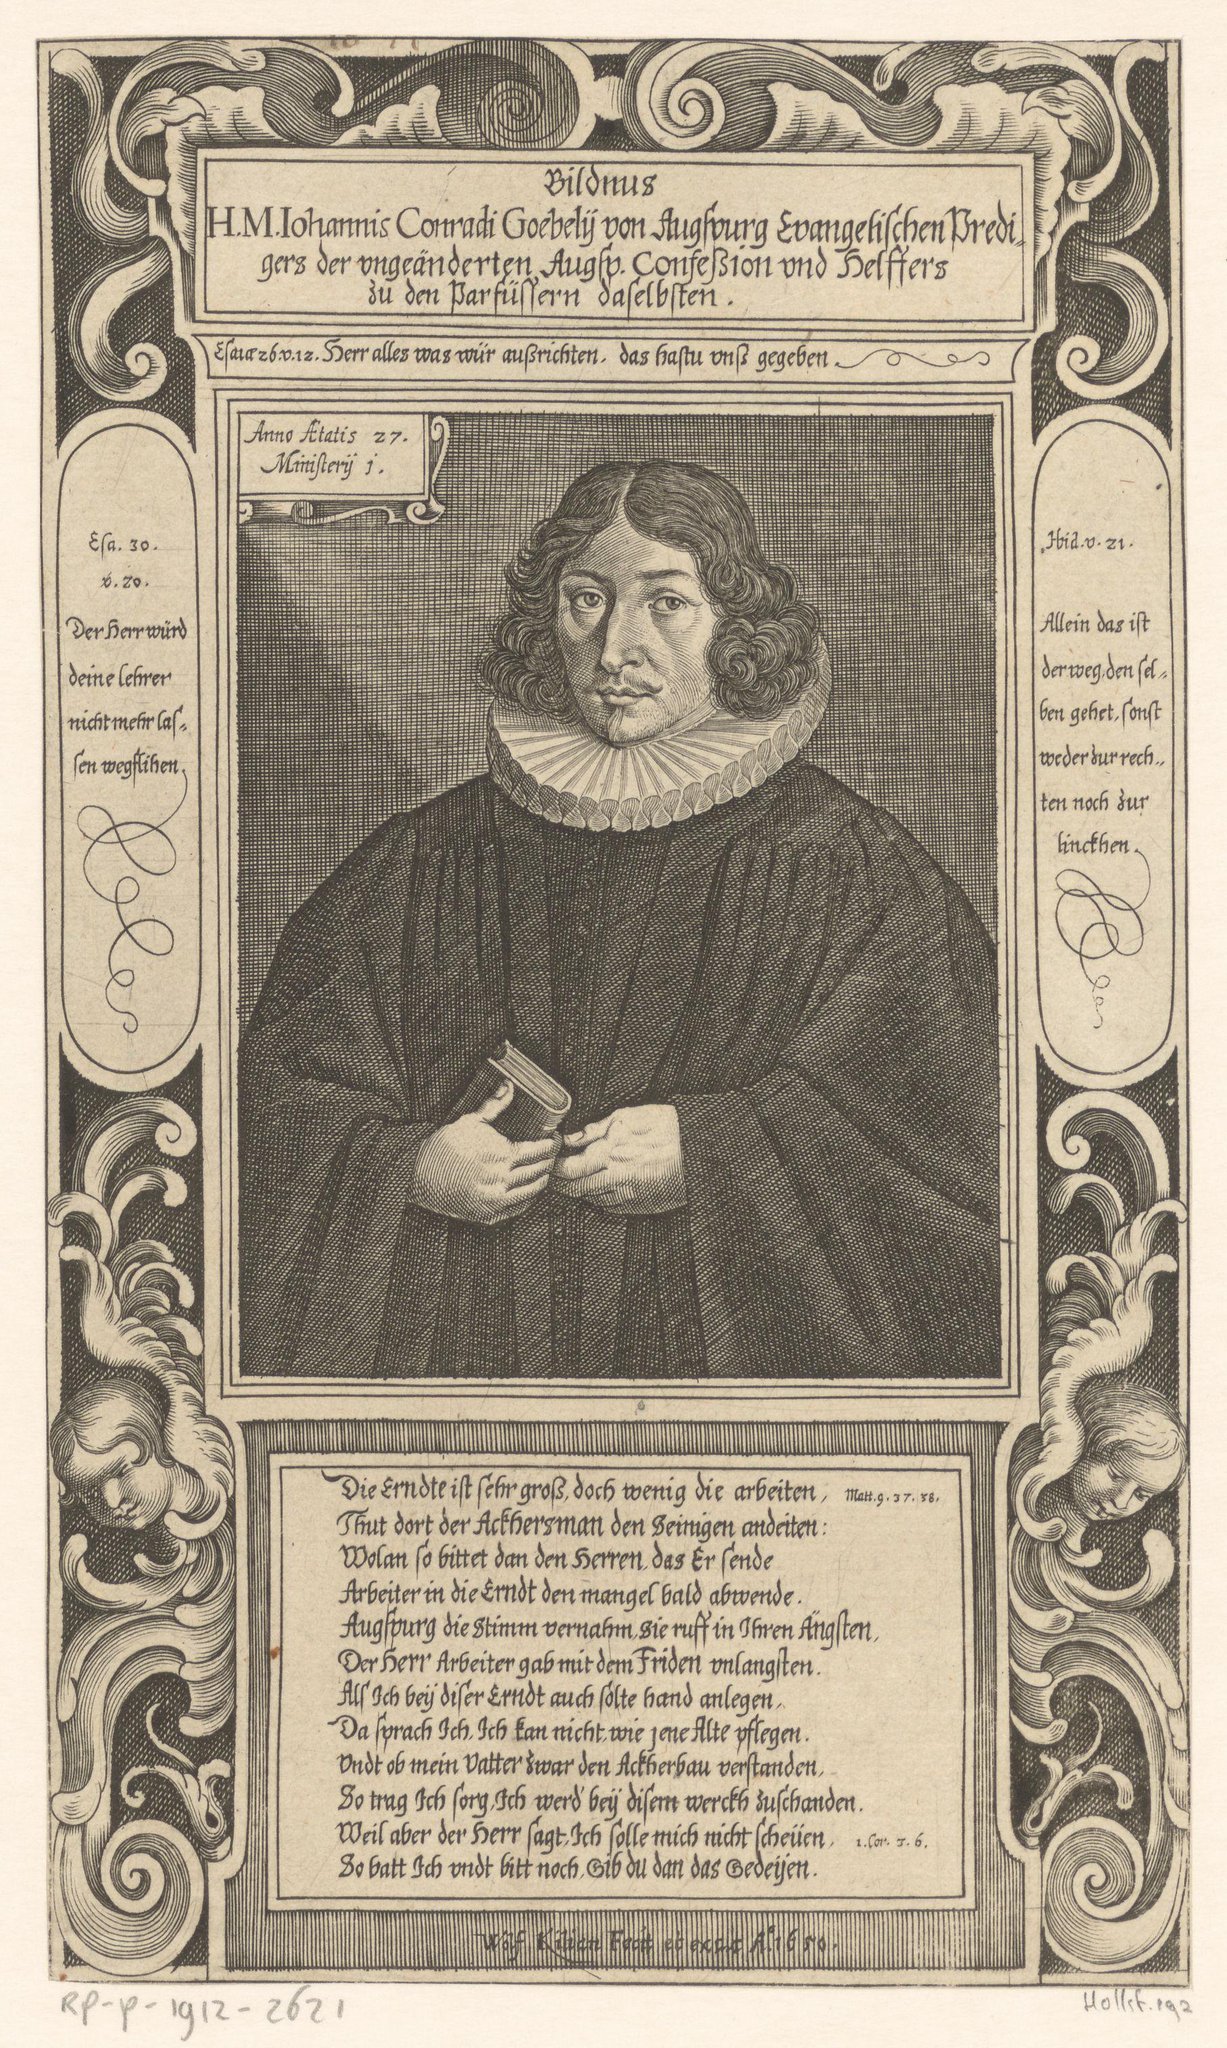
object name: print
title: Portret van Johann Conrad Göbel op 27-jarige leeftijd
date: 1650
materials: paper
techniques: engraving, etching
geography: augsburg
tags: augsburg, theologian, historical persons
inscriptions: collector's mark: Lugt 2228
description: Tekst in het Duits over de geportretteerde en de Bijbelpassages Mat. 9:37-38, Cor. 3-6, en Jes. 30:20-21 in de kaders in de marges met rolwerk en engelenkoppen.